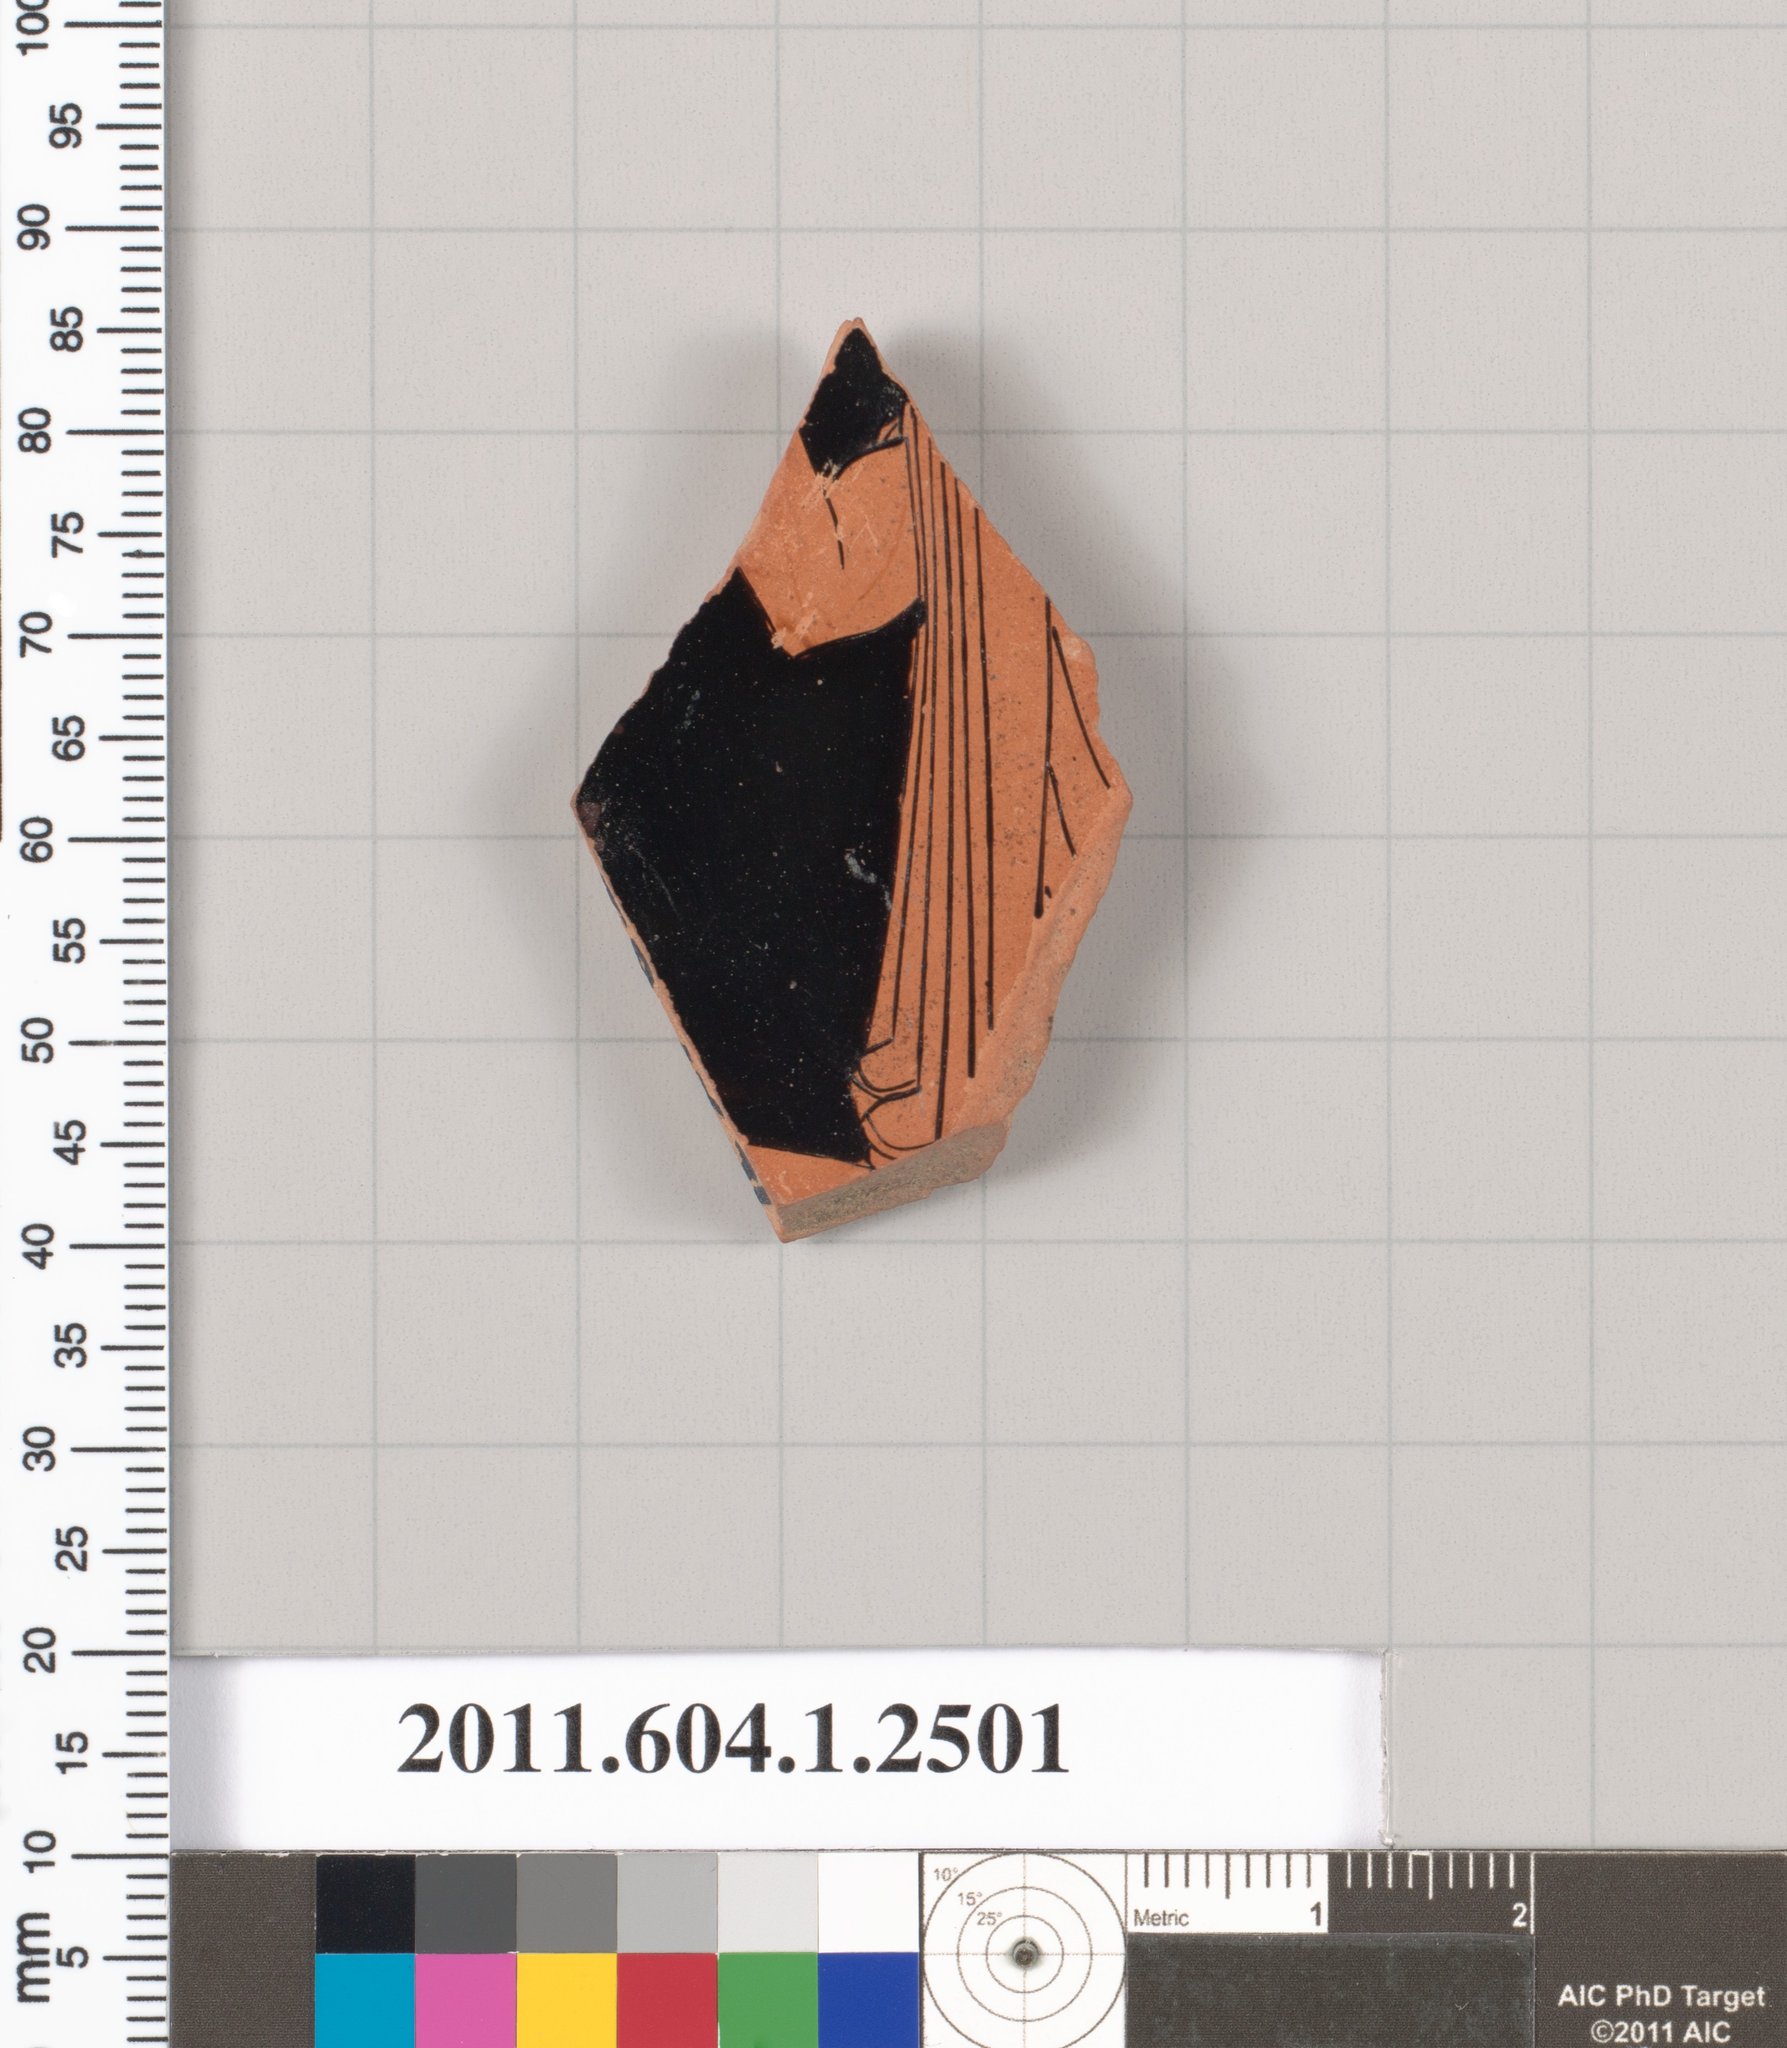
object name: kylix fragment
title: Terracotta fragment of a kylix (drinking cup)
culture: greek, attic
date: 490-480 BCE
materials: terracotta